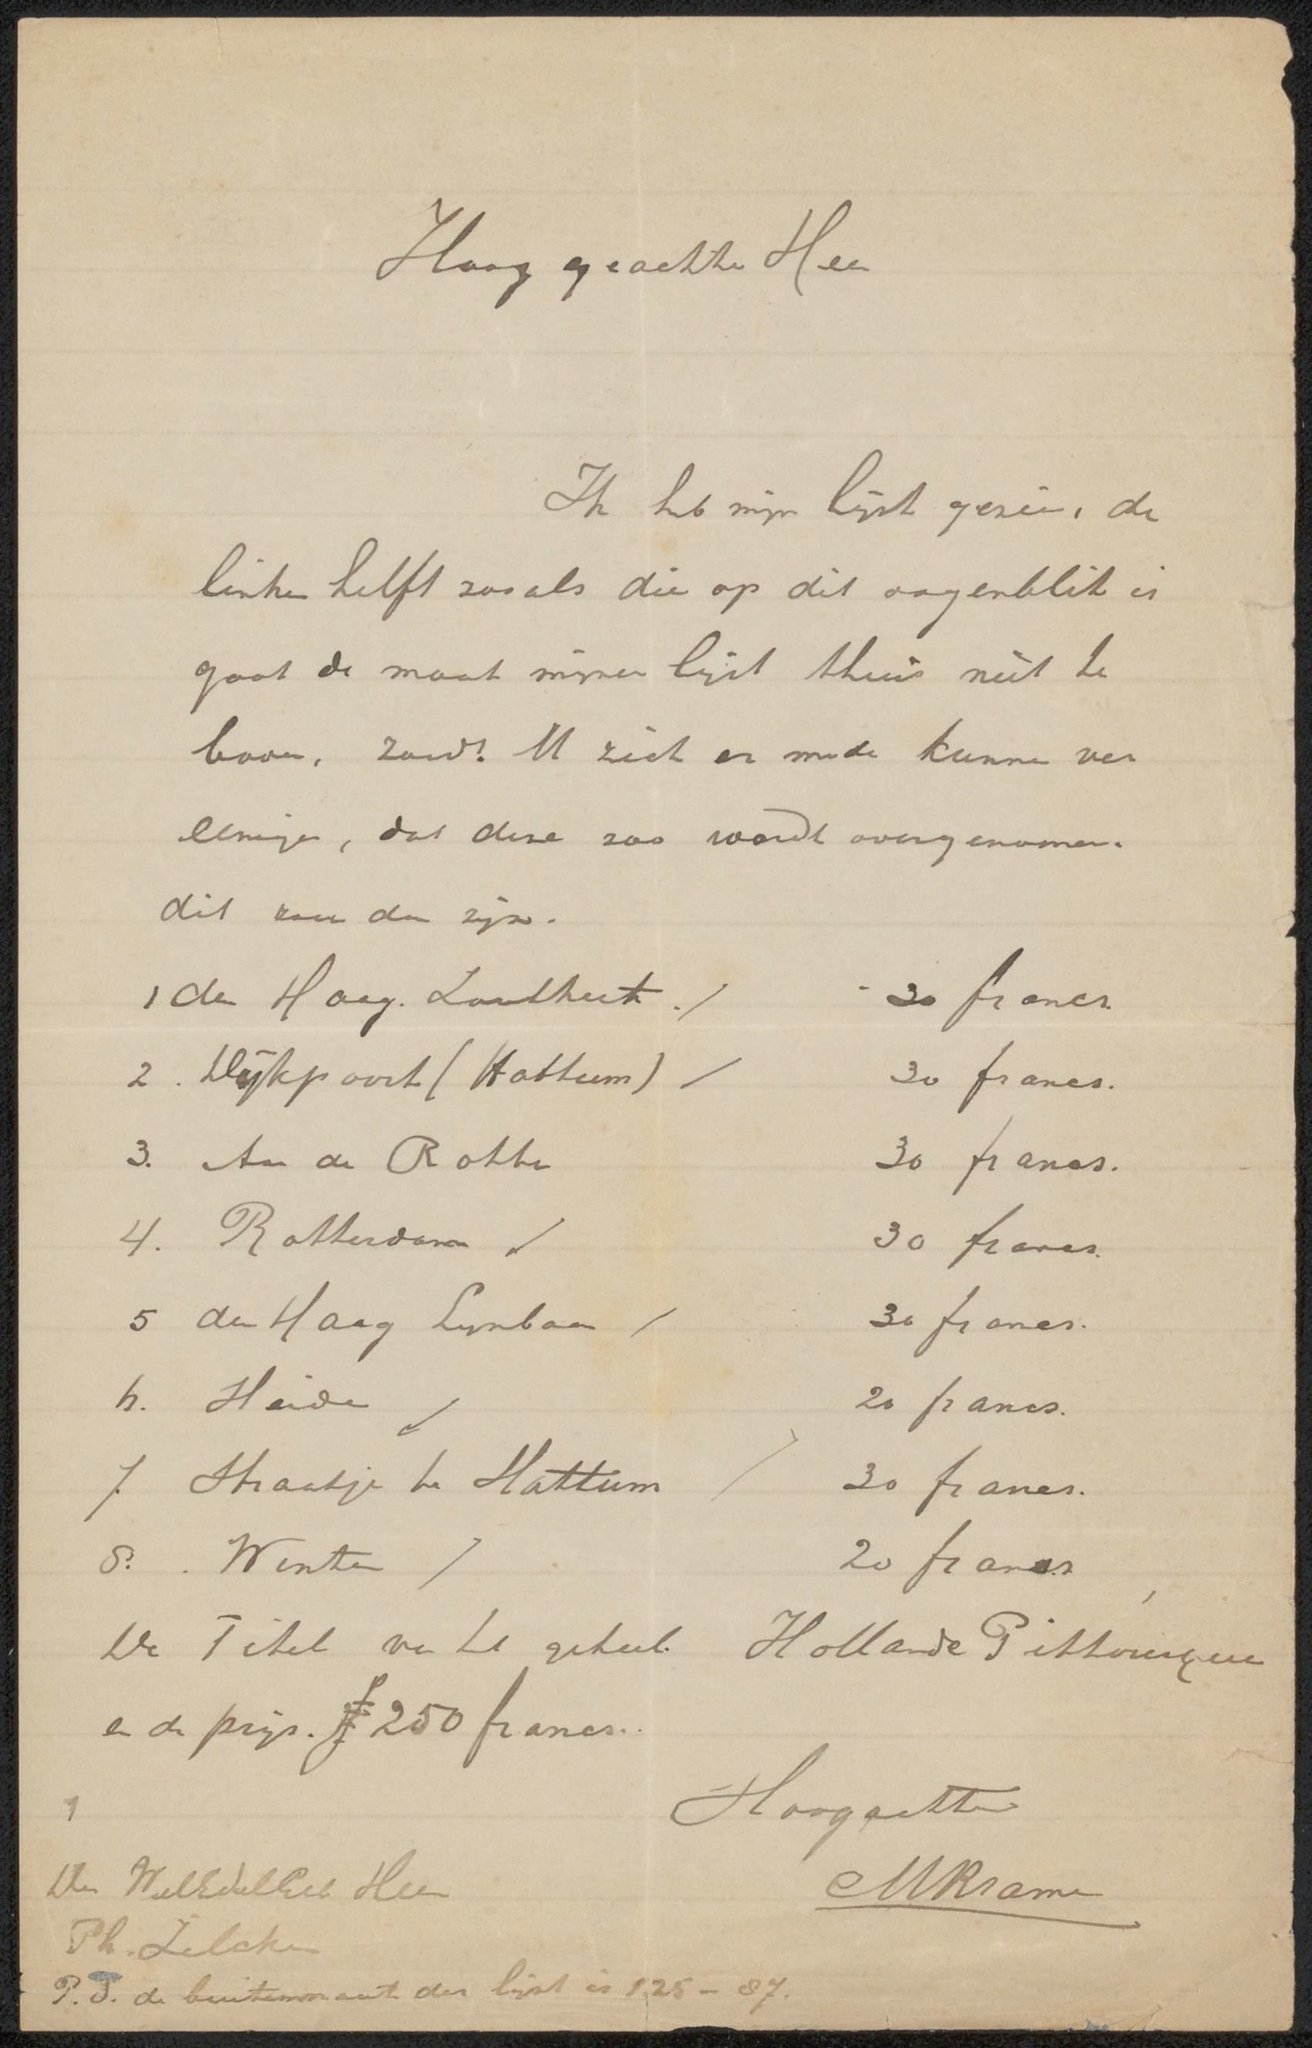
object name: letter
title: Brief aan Philip Zilcken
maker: martinus kramer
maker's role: print maker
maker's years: 1860-1918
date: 1870-1918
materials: ink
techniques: pen, writing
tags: the hague, painter, draughtsman, philip zilcken, money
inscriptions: collector's mark: ‘RPK’